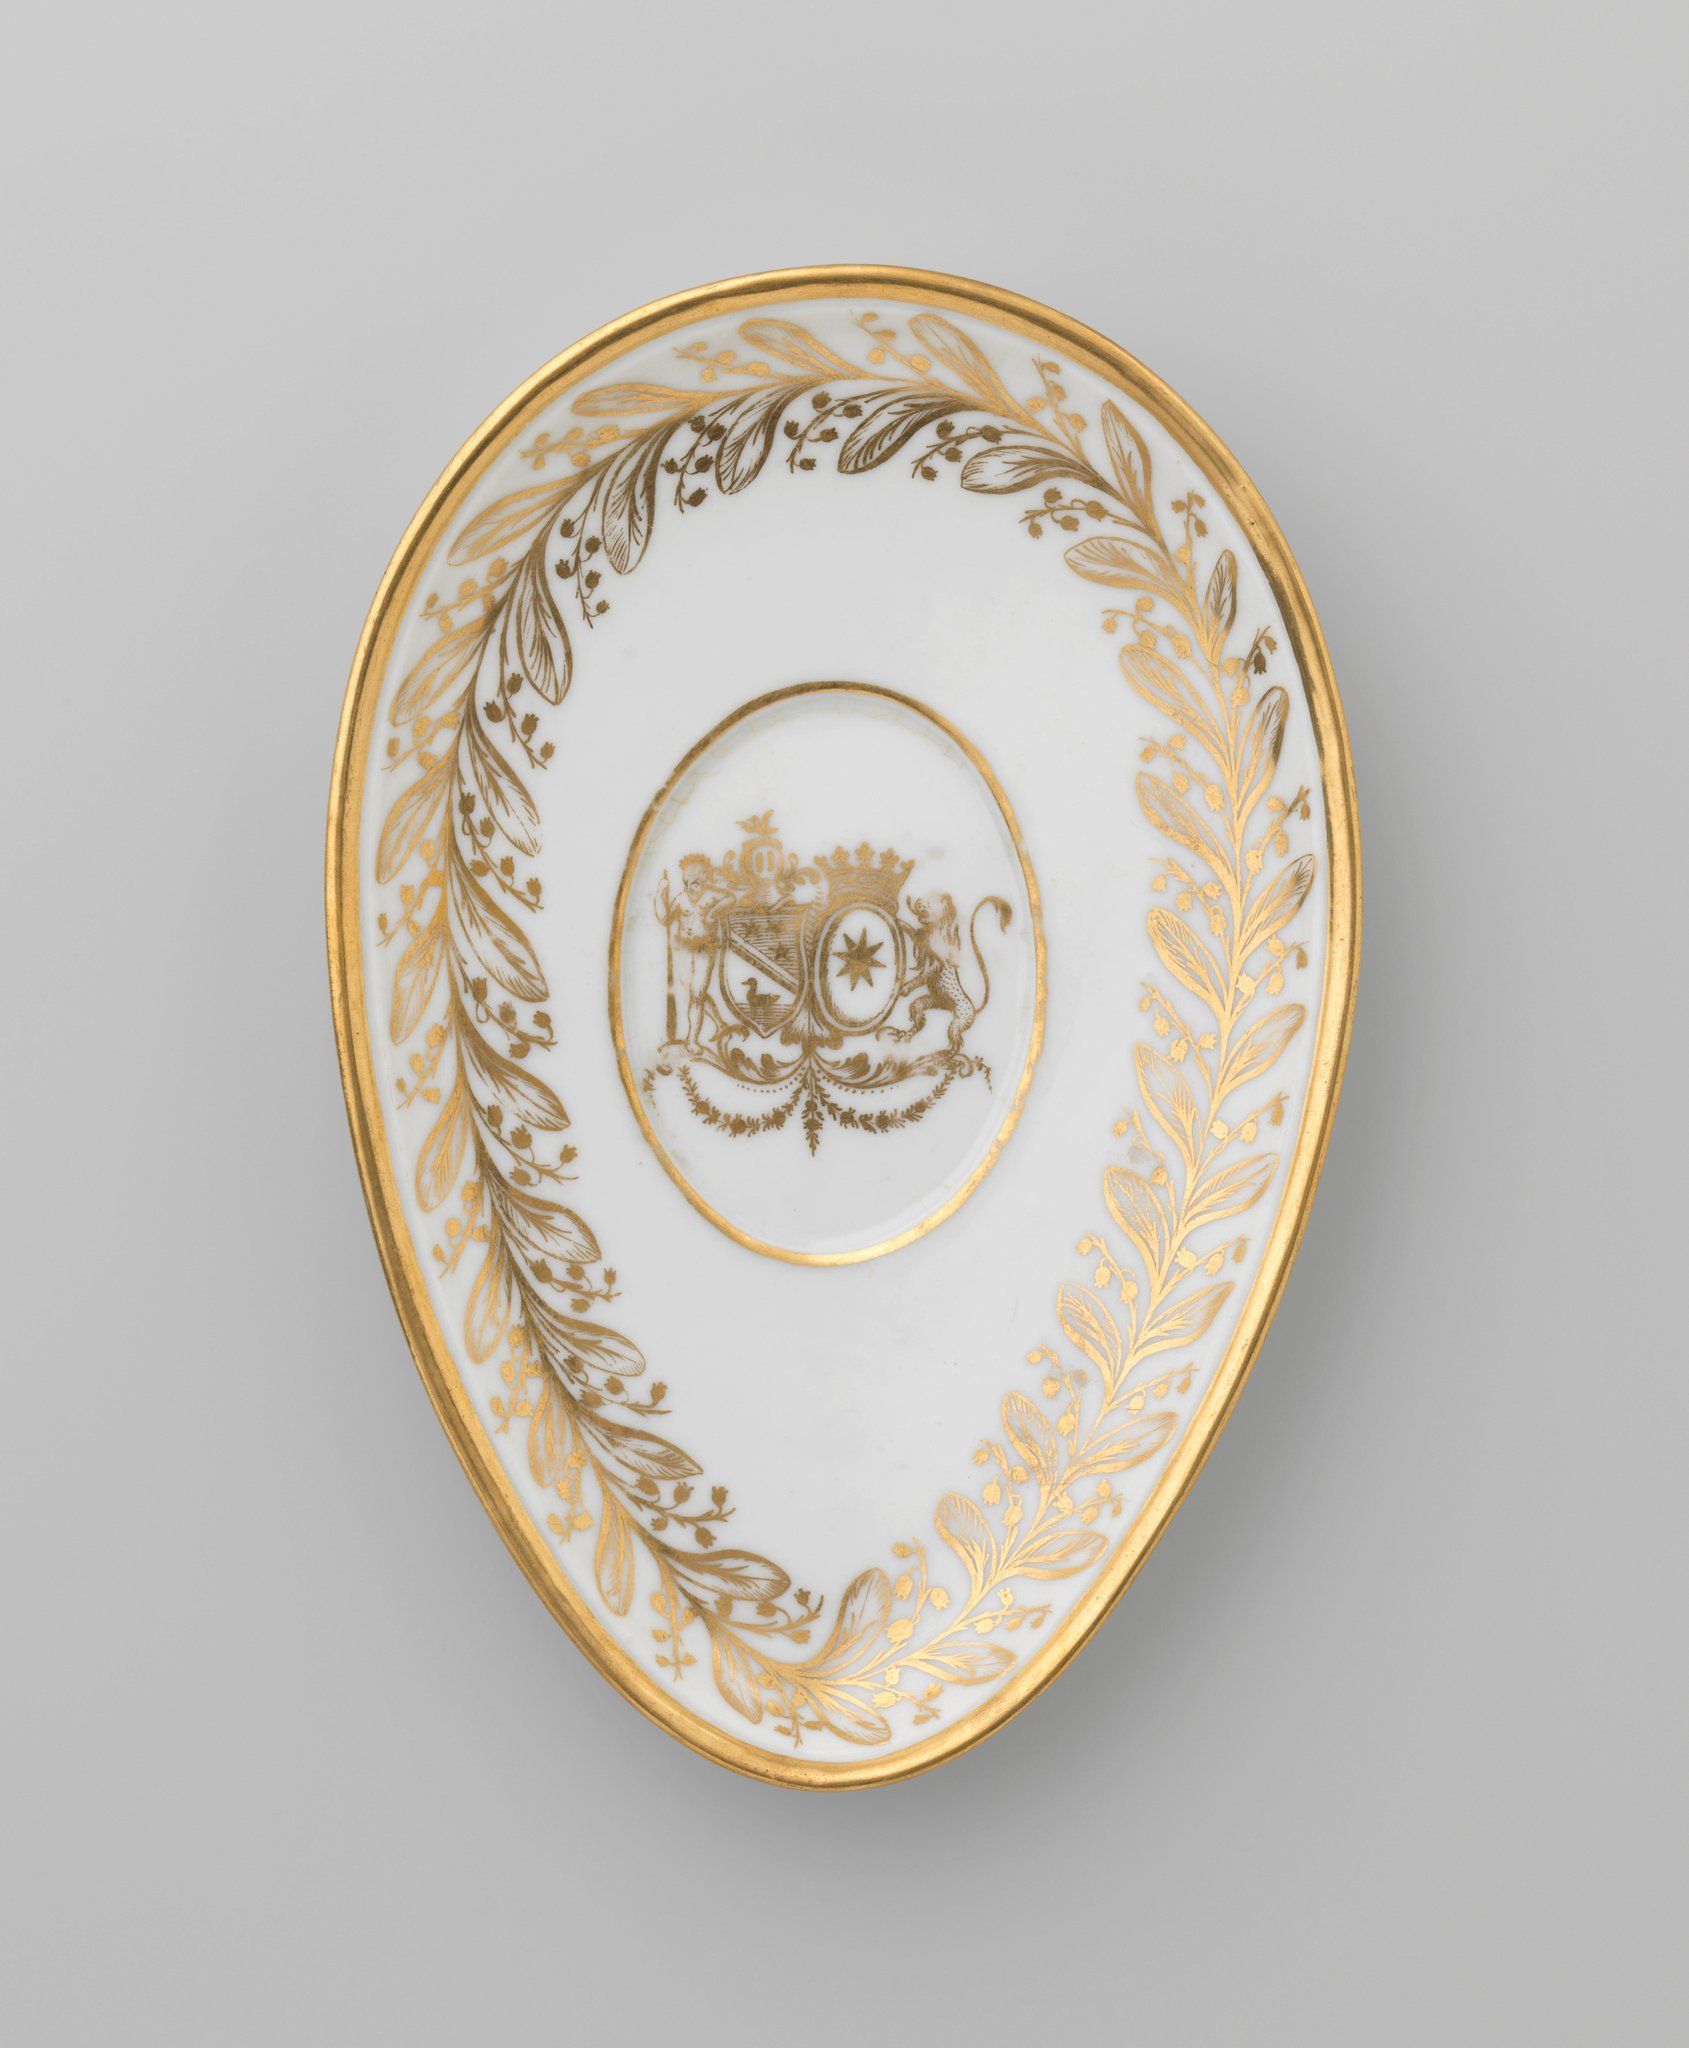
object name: service set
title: Dish with the coat of arms of Hendrik Peter Godfried Quack and Isabella Gertraud von Carnap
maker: Anonymous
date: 1790-1799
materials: glaze, gold, paint, porcelain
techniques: firing, forming, gilding, turning, vitrification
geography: low countries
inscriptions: mark: ‘X’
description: Ovale schotel van een sauskom van porselein, waarbij één zijde spits toeloopt. Beschilderd op het glazuur met goud. Op het plat het alliantiewapen van Hendrik Peter Godfried Quack en Isabella Gertraud von Carnap. De binnenwand met een bloemrank en een gouden band op de rand. Drie proenen op de onderzijde. Gemerkt op de onderzijde met X.